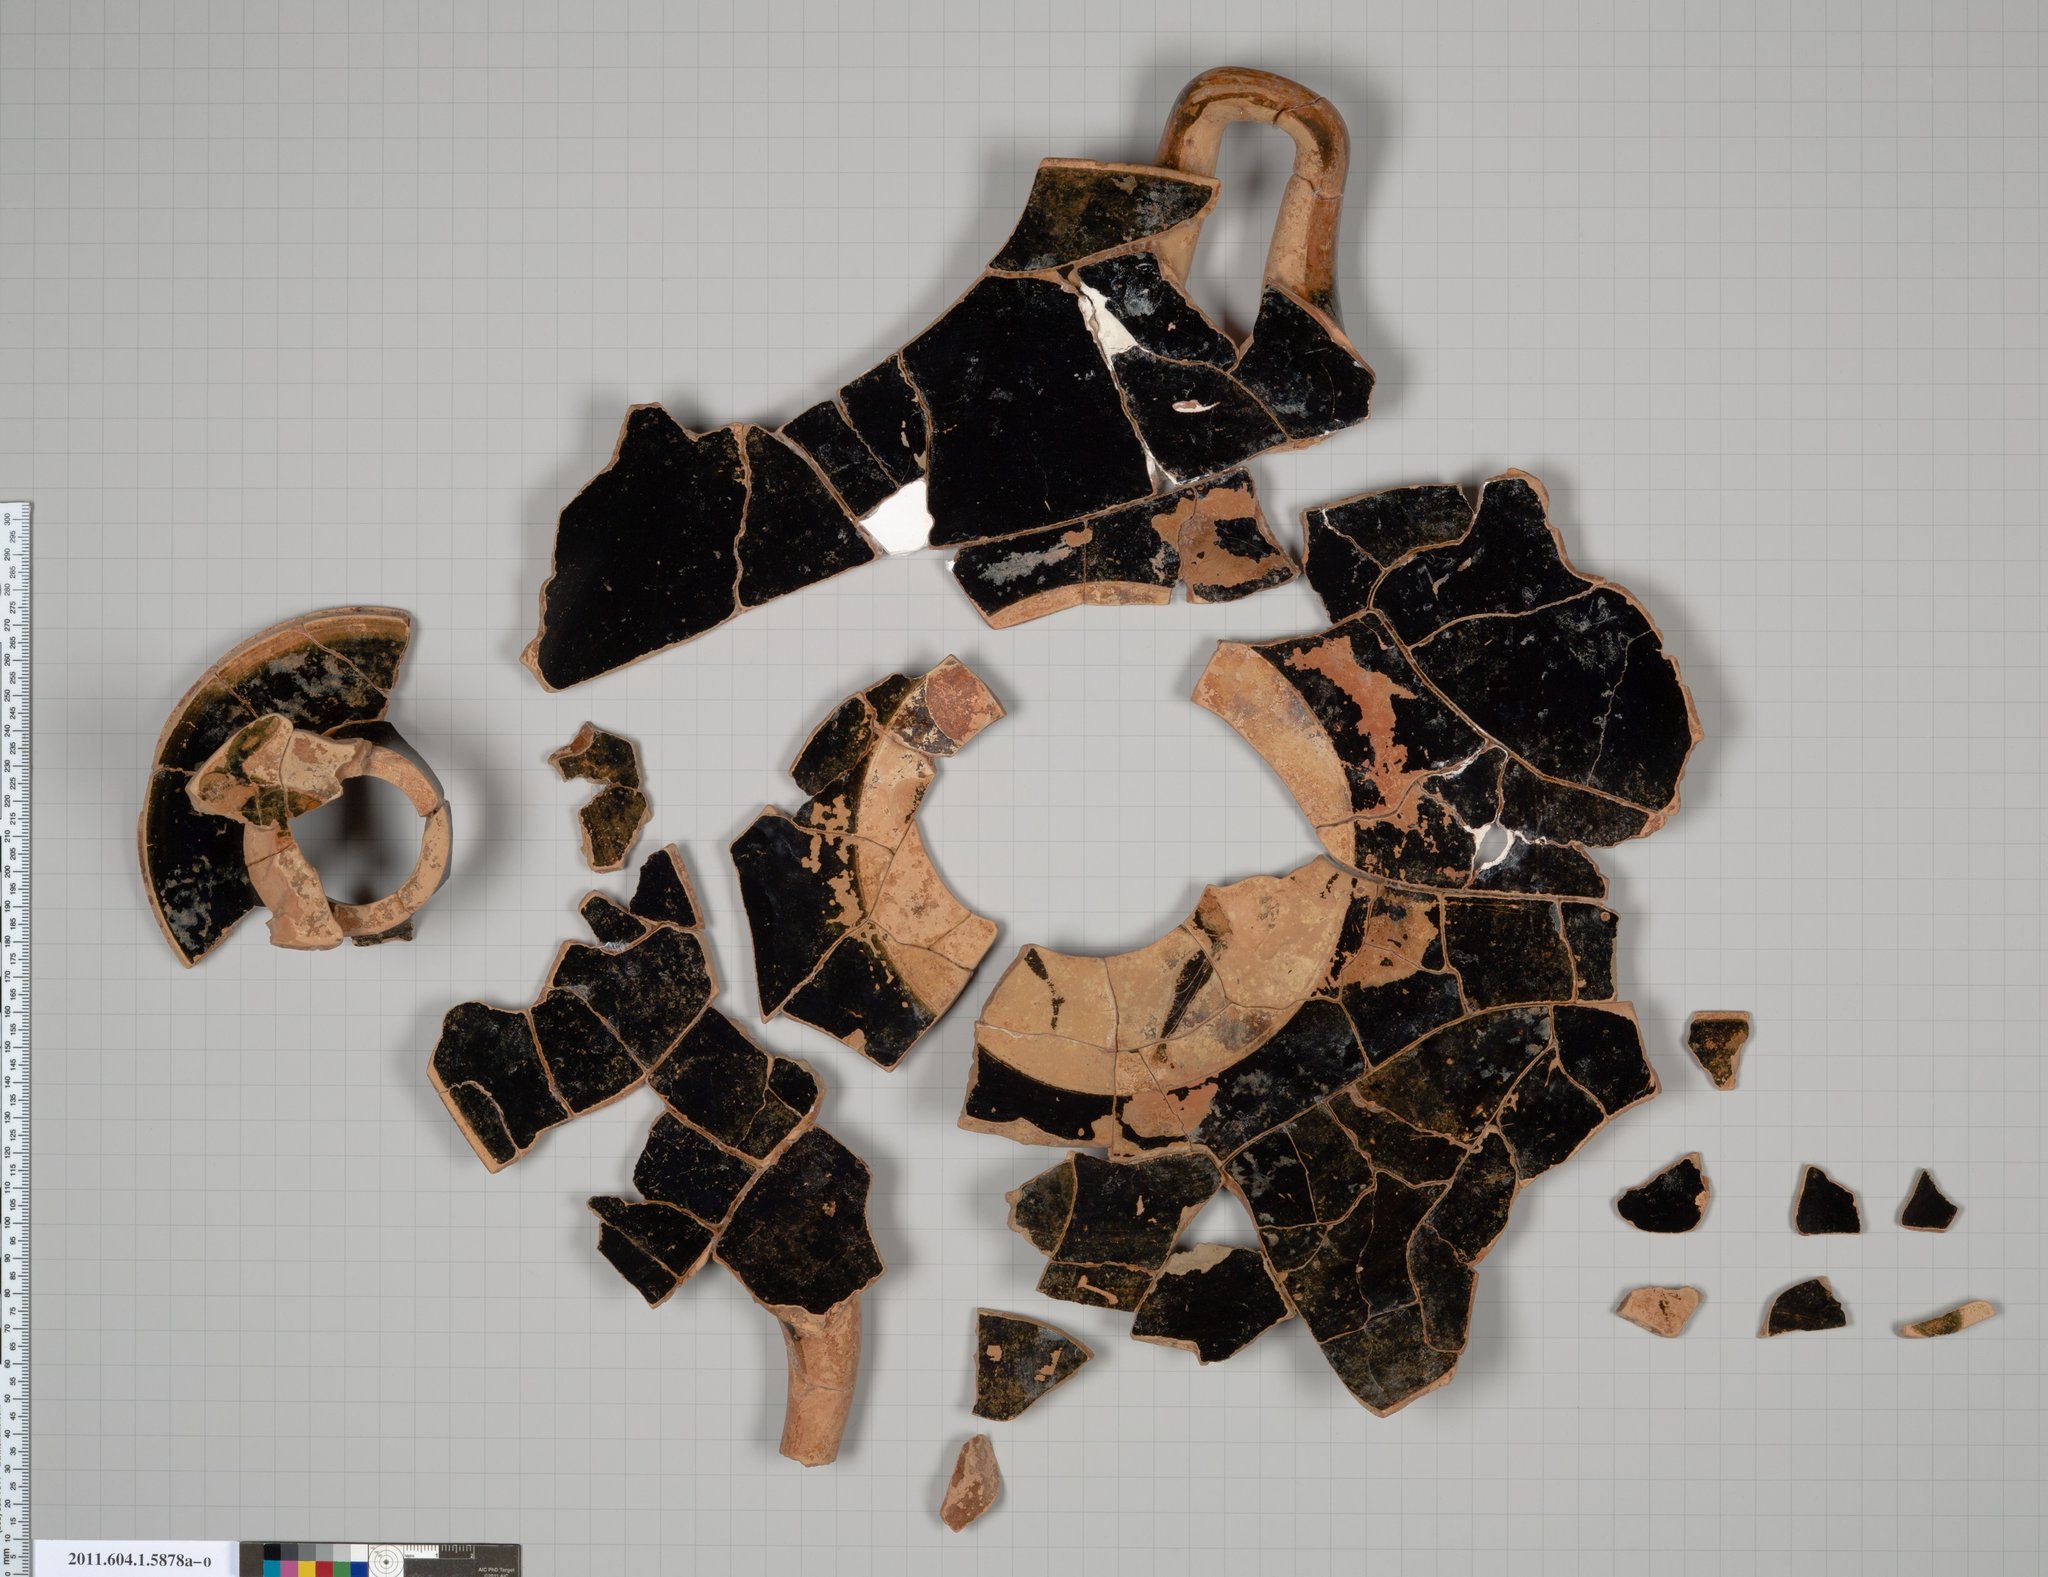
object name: kylix fragment, eye cup, bilingual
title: Terracotta fragments of a kylix (drinking cup)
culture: greek, attic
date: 433-567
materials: terracotta